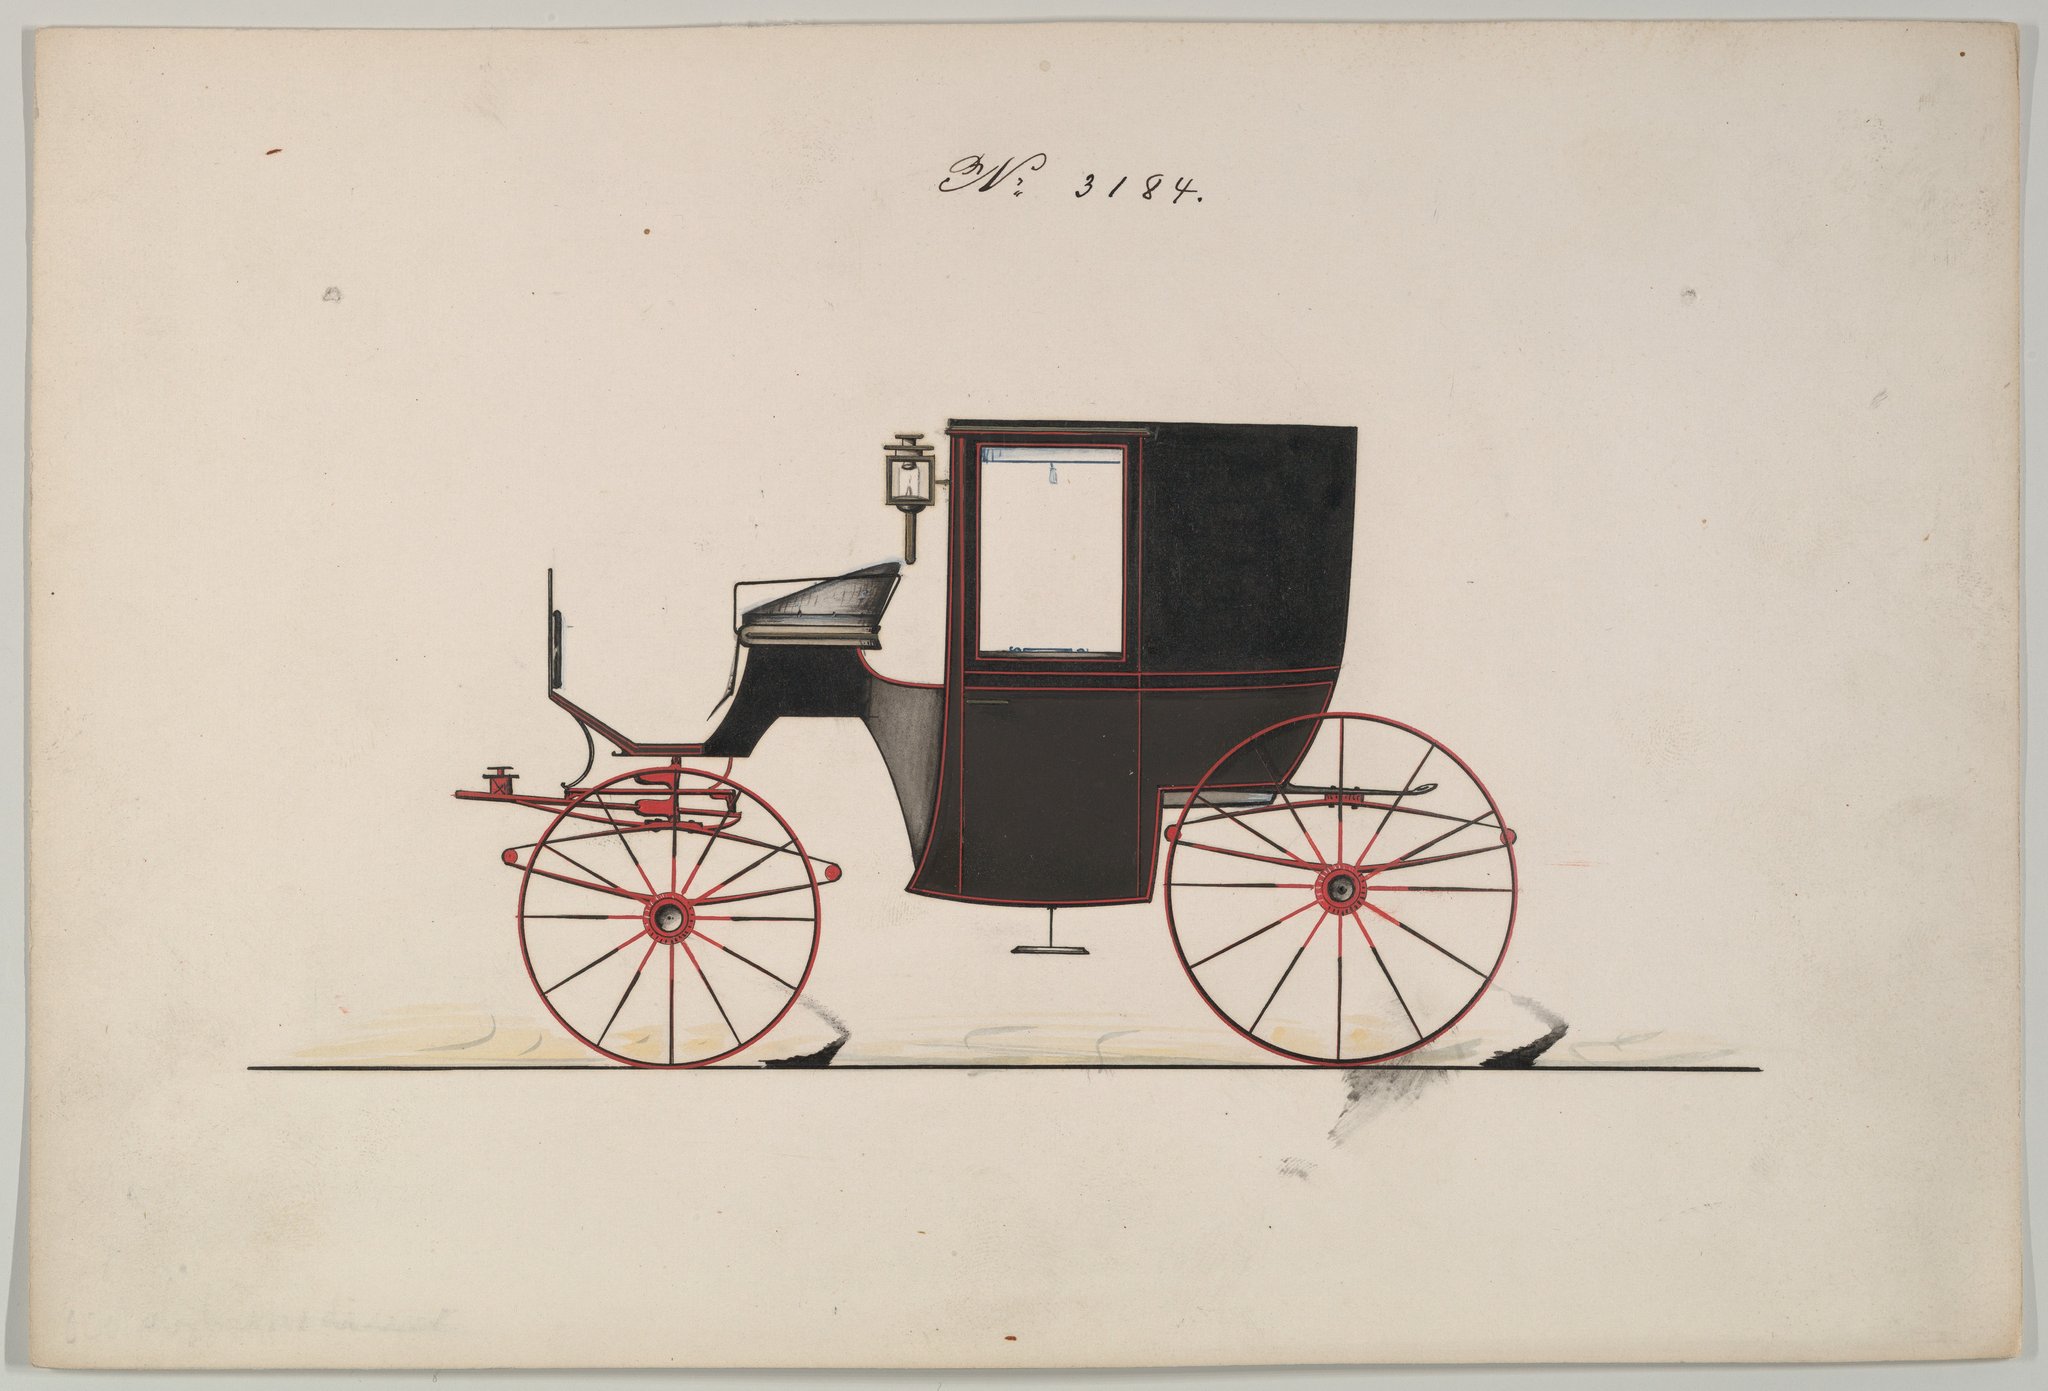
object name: drawing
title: Brougham #3184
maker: brewster & co.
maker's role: manufacturer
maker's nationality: american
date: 1876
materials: gouache, ink, watercolor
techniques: pen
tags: carriages